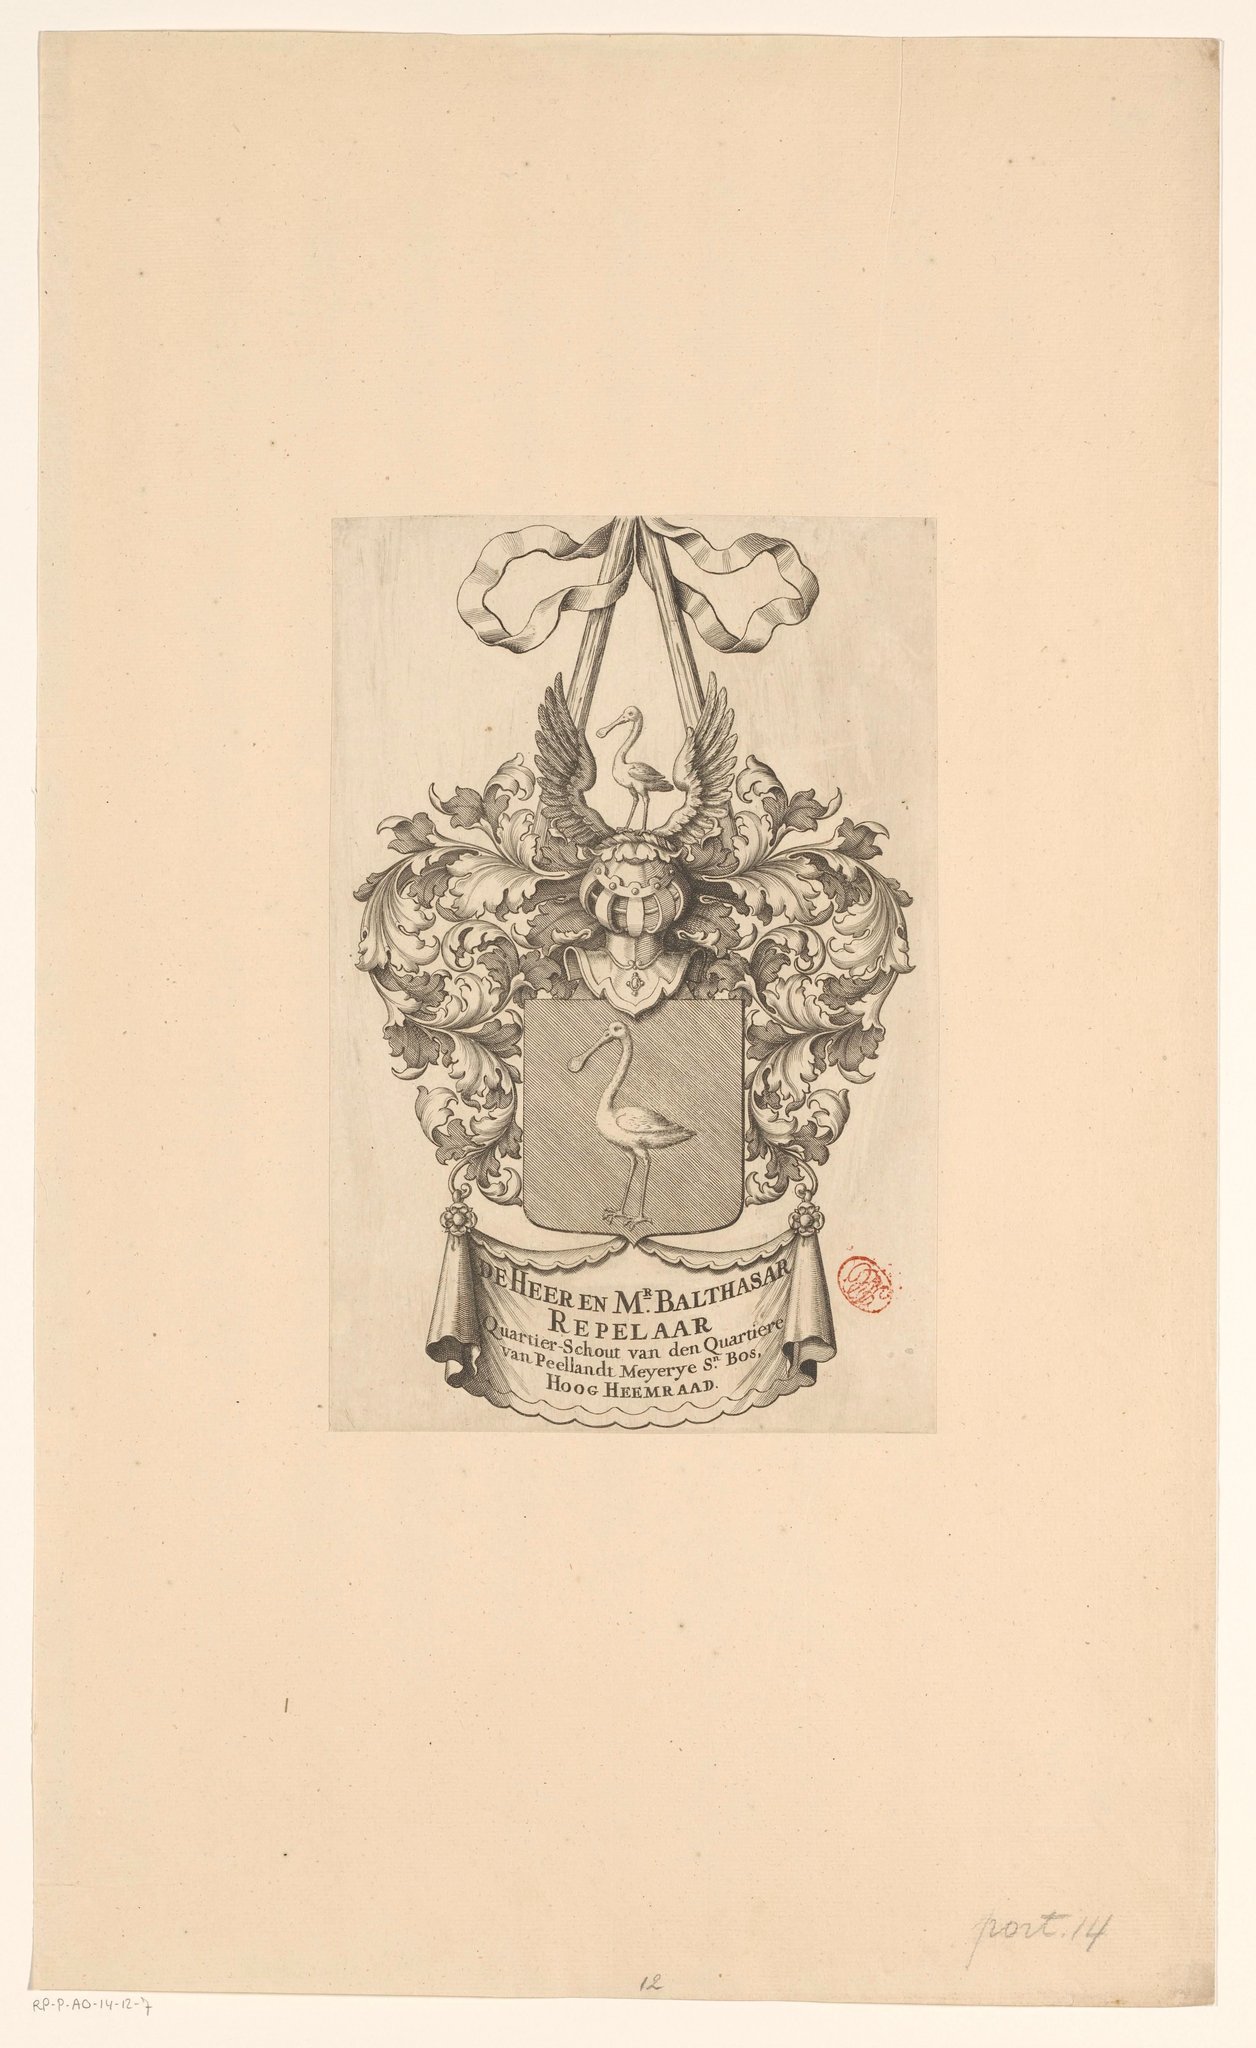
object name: print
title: Wapenschild van Balthasar Repelaar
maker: Anonymous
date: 1716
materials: paper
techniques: engraving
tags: armorial bearing, heraldry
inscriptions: collector's mark: Lugt 195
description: Deze prent is onderdeel van de wapenrand van de tweede druk (1716) van 'Den Alblasser Waard en Vyf Heeren Landen, te samen groot 33110. mergen / Nieuwe caerte vertoonende den geheelen Alblasserwaert', een vierdelige kaart van de Alblasserwaard en de Vijfheerenlanden (zie RP-P-AO-14-12). Van deze kaart zijn voor zover na te gaan vijf verschillende drukken bekend, uit respectievelijk 1681, 1716, 1730, 1741 en 1767. De kaart zelf is gedrukt van vier platen. In eerste instantie werden de wapens van de dijkgraaf, hoogheemraden en penningmeester/secretaris op de platen van de kaart gegraveerd. Voor de druk van 1716 werden deze wapenschilden van de platen afgesneden, werden de platen bijgewerkt en werd een aparte sierrand met de wapenschilden gemaakt. Voor de daaropvolgende drukken zou de wapenrand telkens aangepast en/of vernieuwd worden naar samenstelling van het bestuur van het hoogheemraadschap (waarschijnlijk werd de kaart telkens als een nieuwe dijkgraaf aantrad opnieuw uitgegeven met bijhorende wapenrand). Omdat er geen gemonteerde versie van de wapenrand bekend is en daarom onduidelijk is hoe deze er precies uit heeft gezien, is de wapenrand niet virtueel samengevoegd maar zijn de verschillende onderdelen wel te vinden onder RP-P-AO-14-12B.